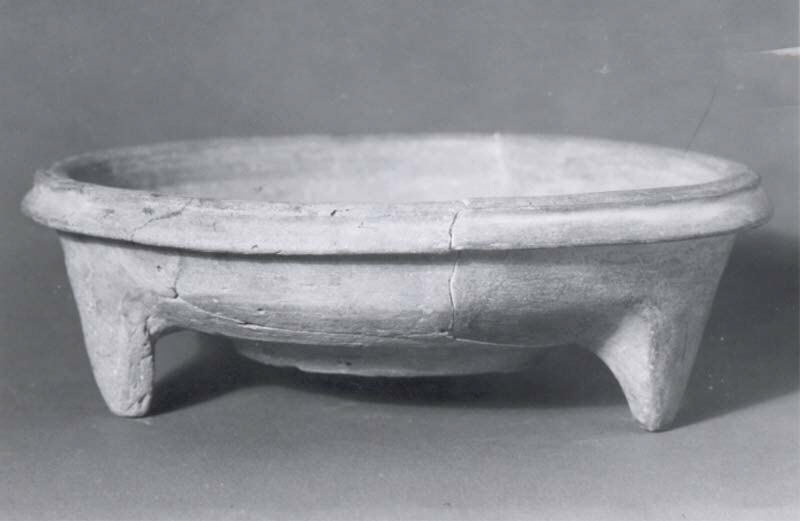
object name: bowl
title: Tripod bowl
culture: assyrian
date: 800-601 BCE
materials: ceramic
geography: mesopotamia